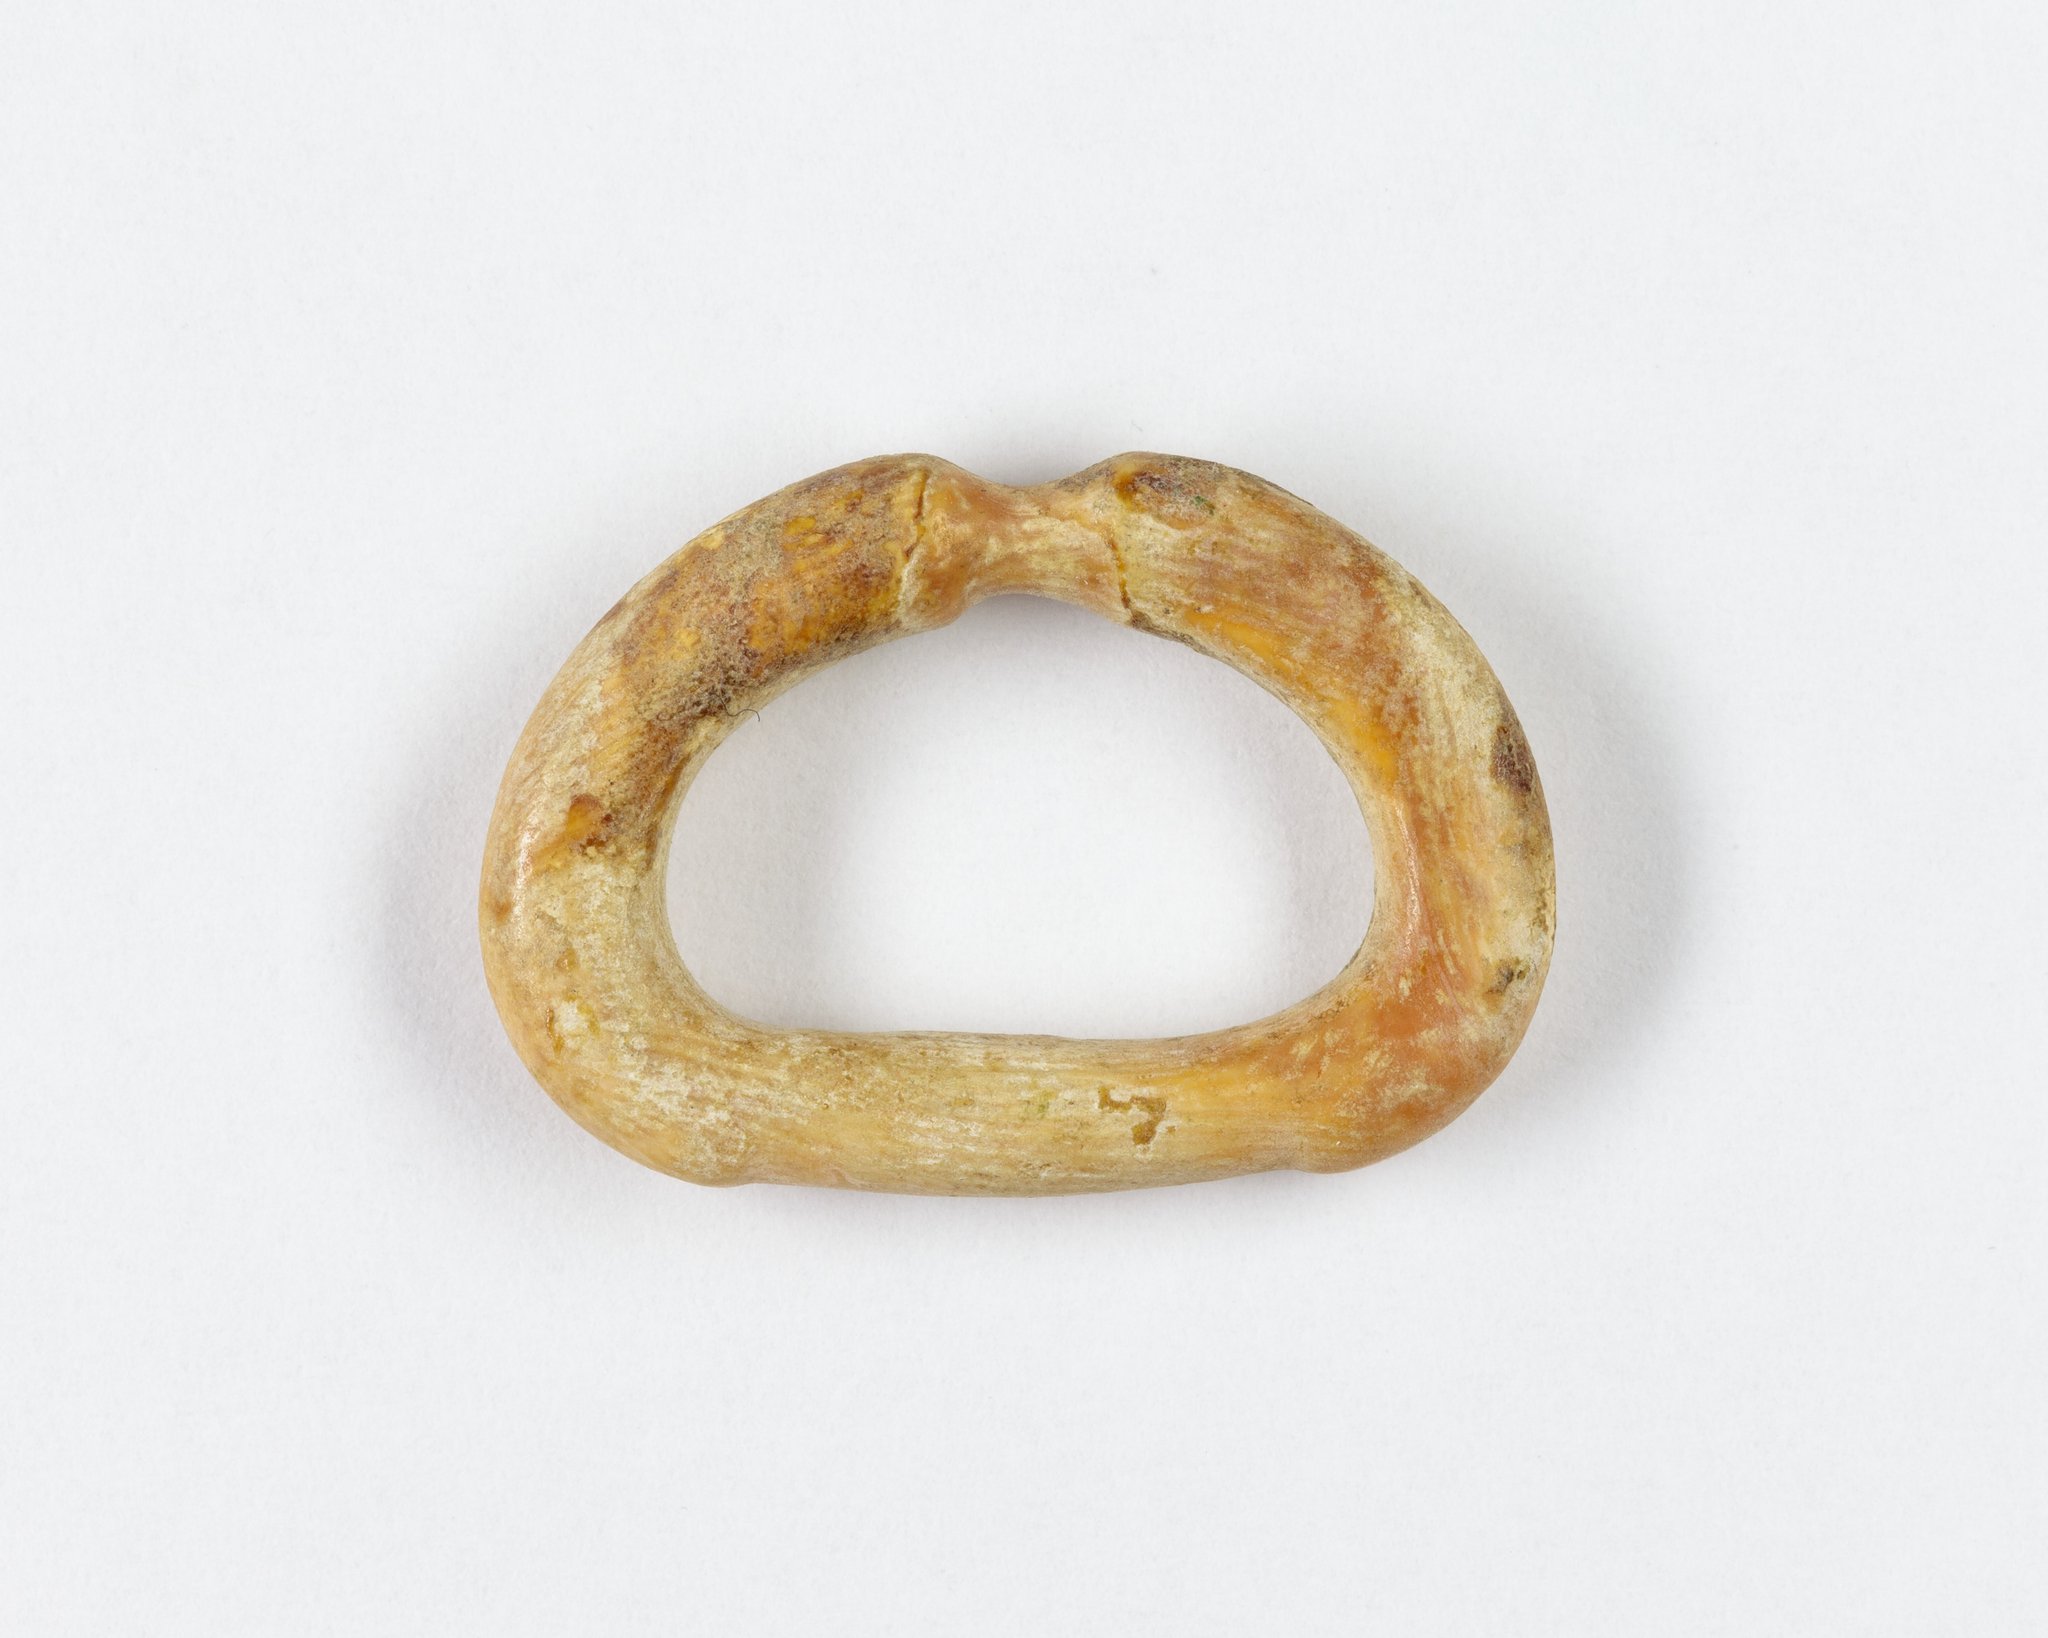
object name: ring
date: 1550-1295 BCE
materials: bone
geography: northern upper egypt